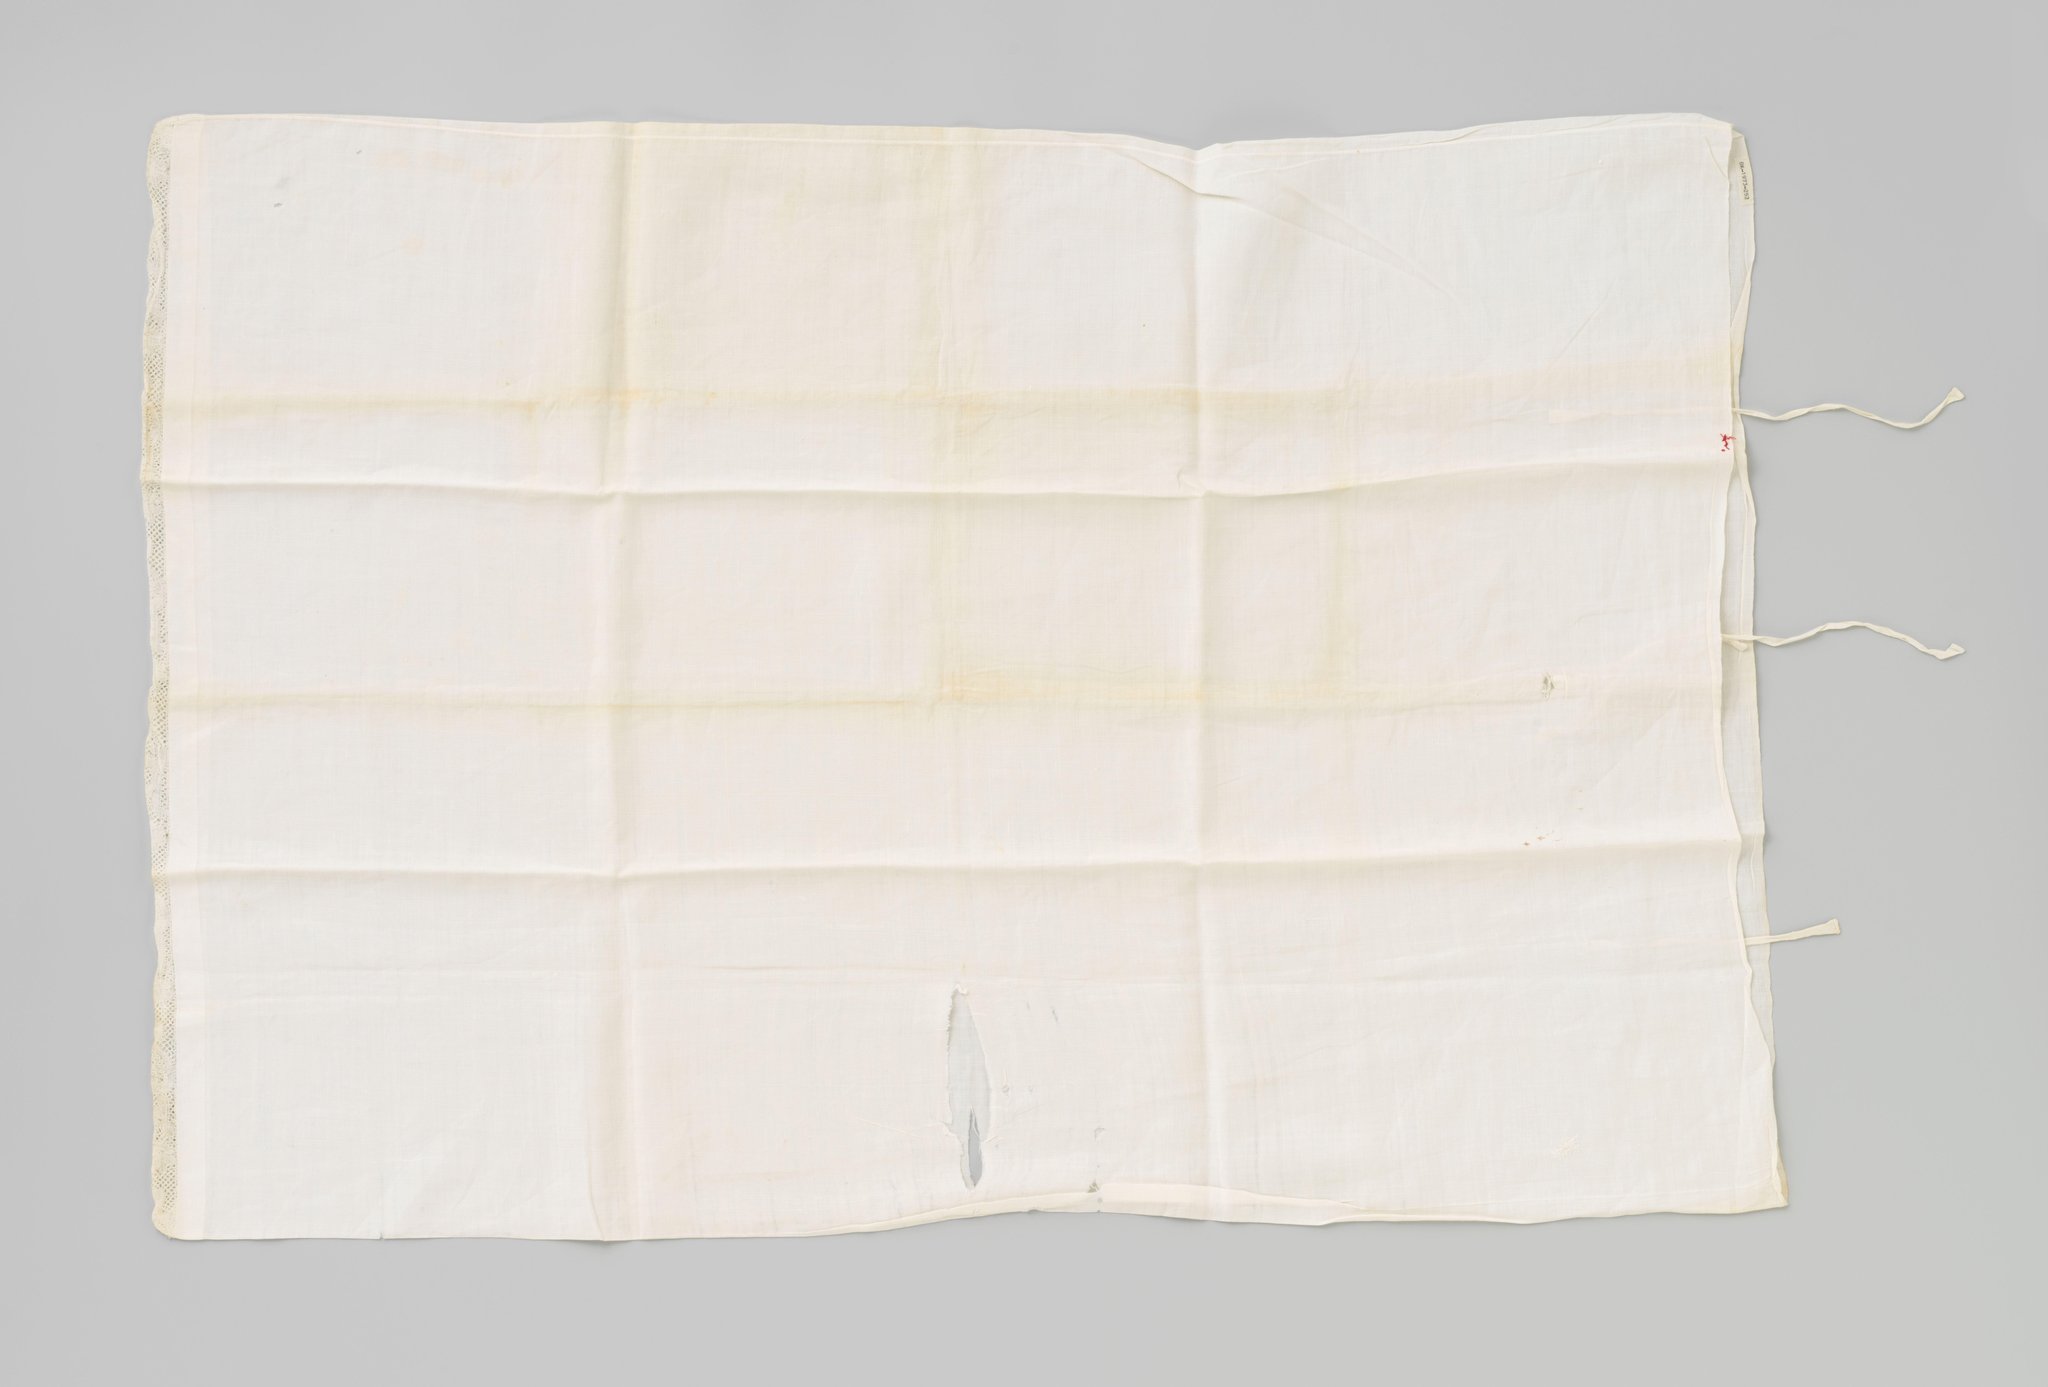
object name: sloop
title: Kussensloop van linnen met entre-deux van kant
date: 1700-1800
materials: linen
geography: netherlands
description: Kussensloop van linnen met entre-deux van kant. Blindmerk: AVW of ADW. N.B. Het blindmerk duidt op Anna (van Haersma) de With van Vierssen of Anna (van Haersma)de With (-van Vierssen). Cornelis Martinus van Haersma de With (1799-1869) trouwt in 1823 Anna Frederika van Vierssen (1802-1884).